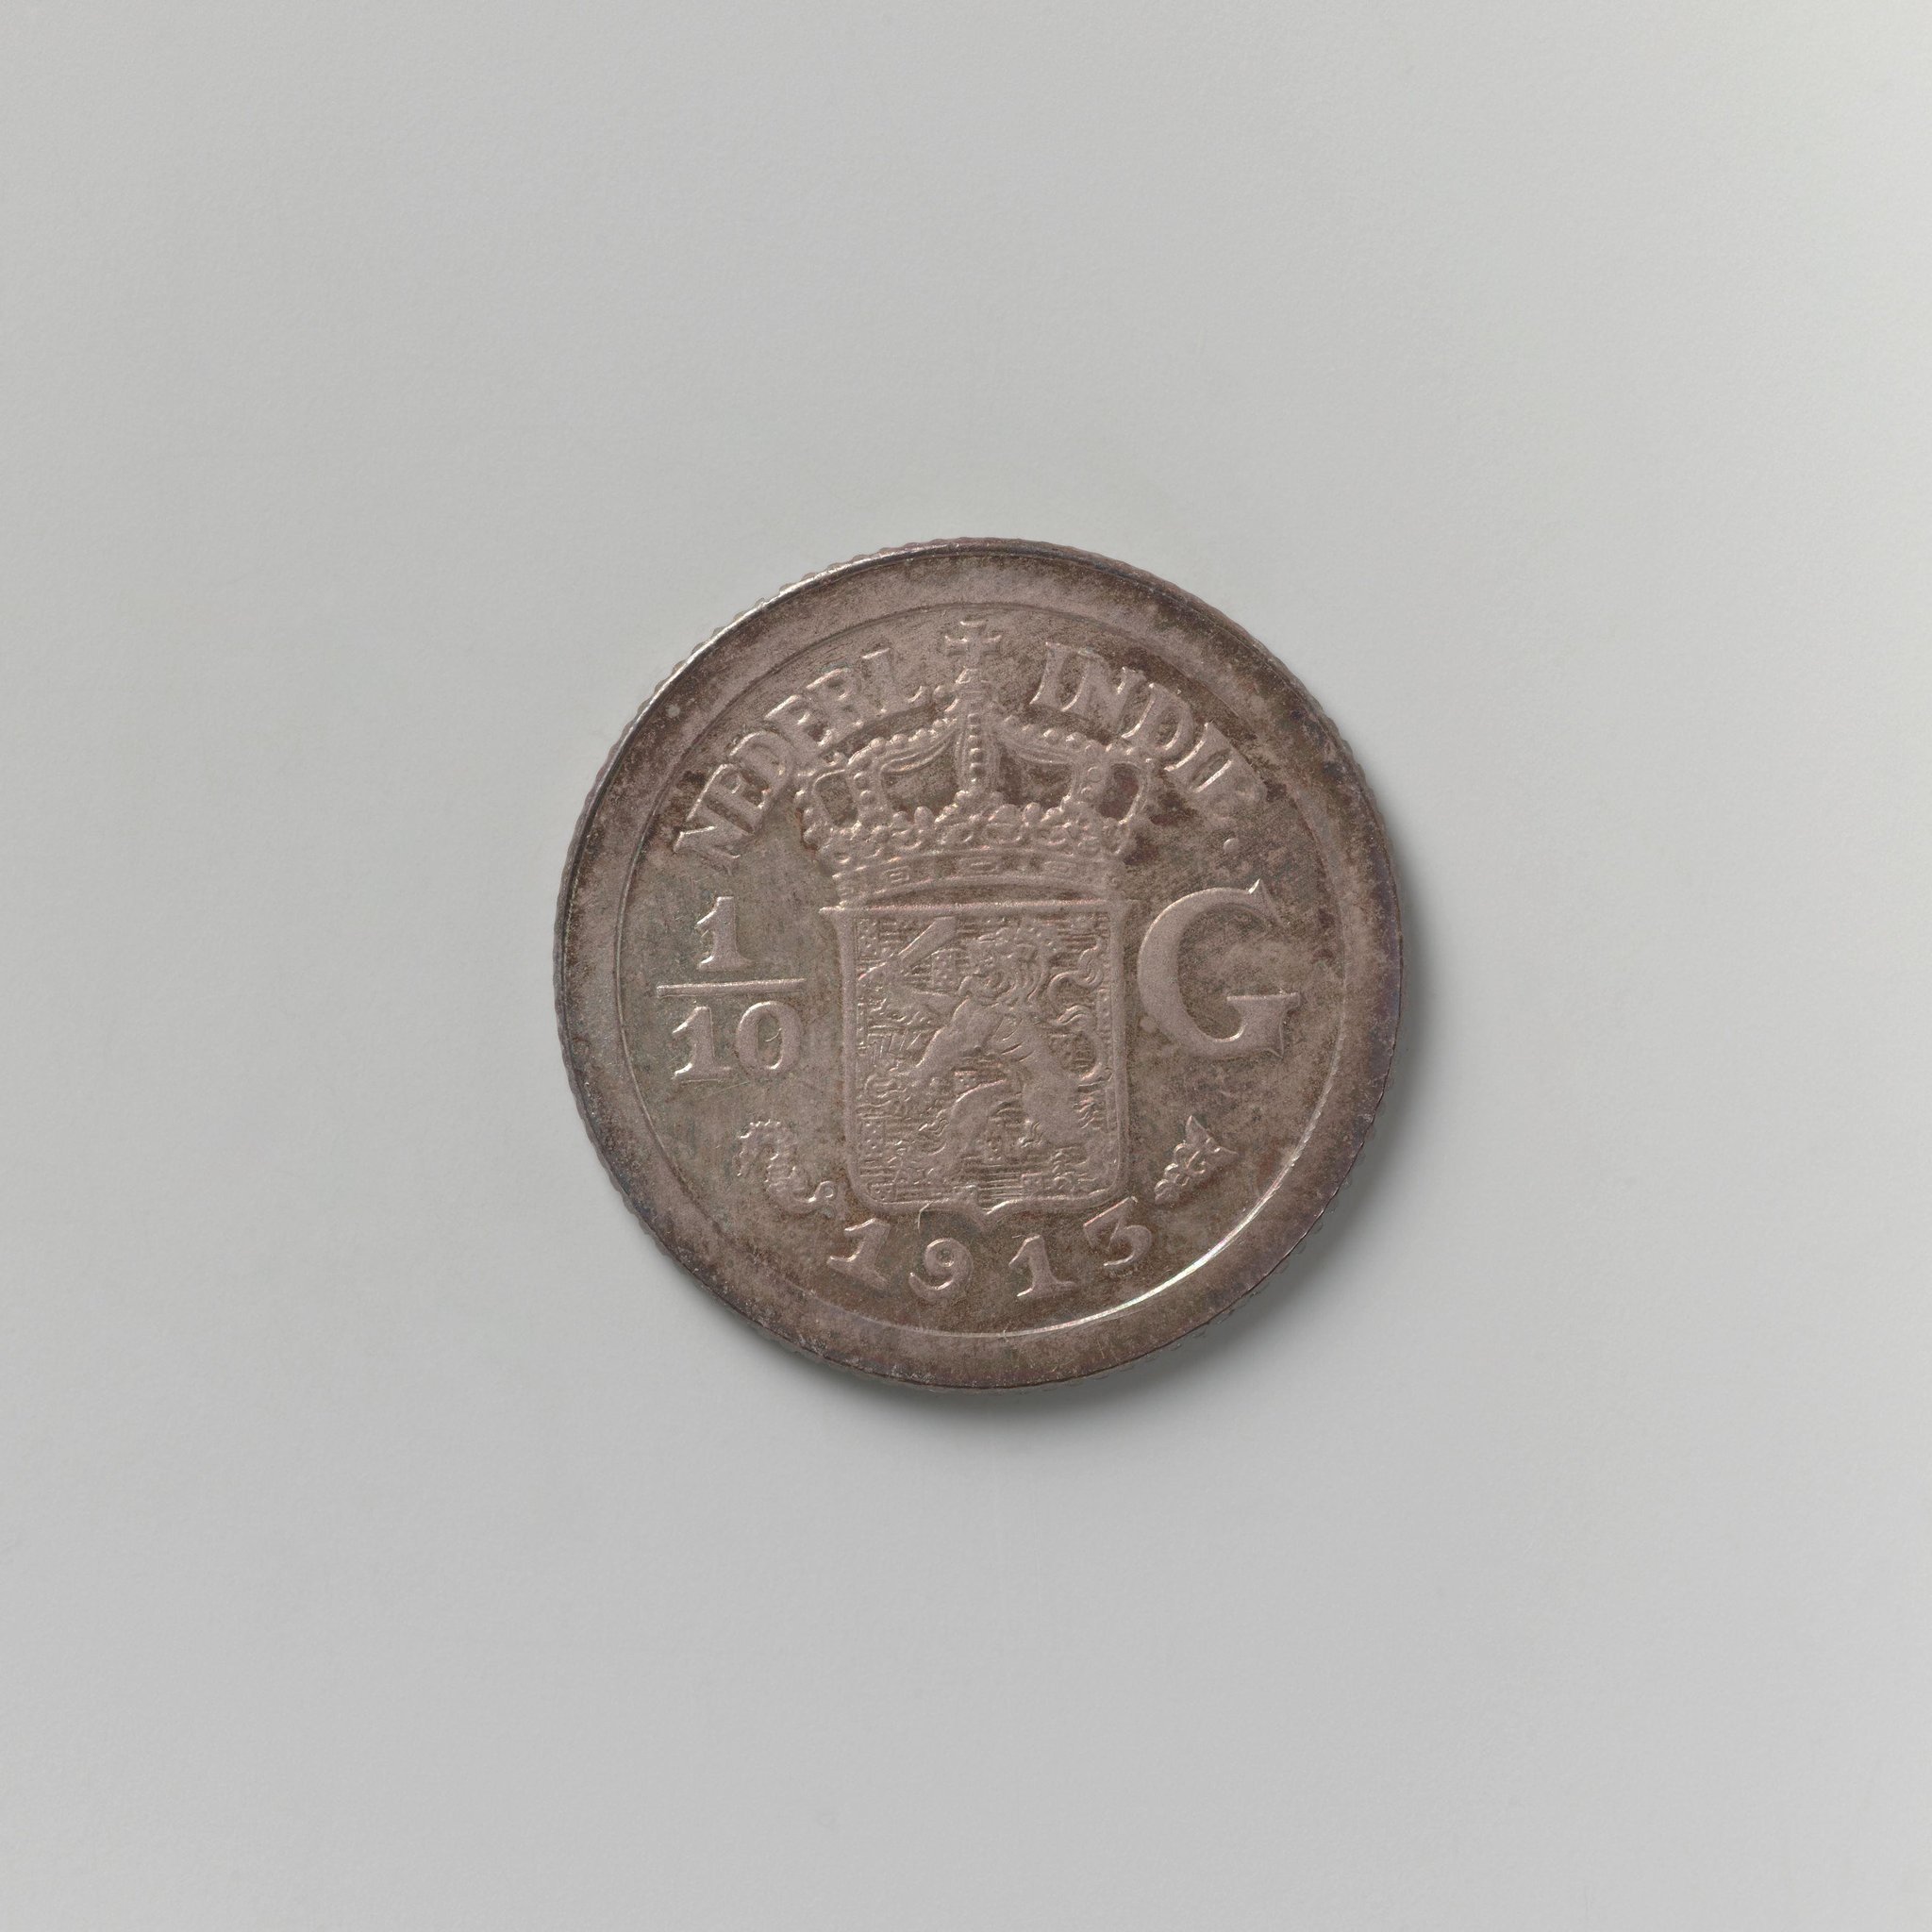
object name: coin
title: 1/10 gulden van Nederlands Indië,1913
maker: wilhelmina of the netherlands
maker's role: print maker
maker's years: 1880-1962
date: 1913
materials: copper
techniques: striking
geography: utrecht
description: Zilveren munt. Voorzijde: tussen waarde-aanduiding 1/10 G gekroond rijkswapenschild. Boven kroon landsaanduiding en onder wapenschild jaartal. Keerzijde: tweeregelig Maleis opschrift in Arabische tekens, waaromheen omschrift in het Javaans. Kartelrand.